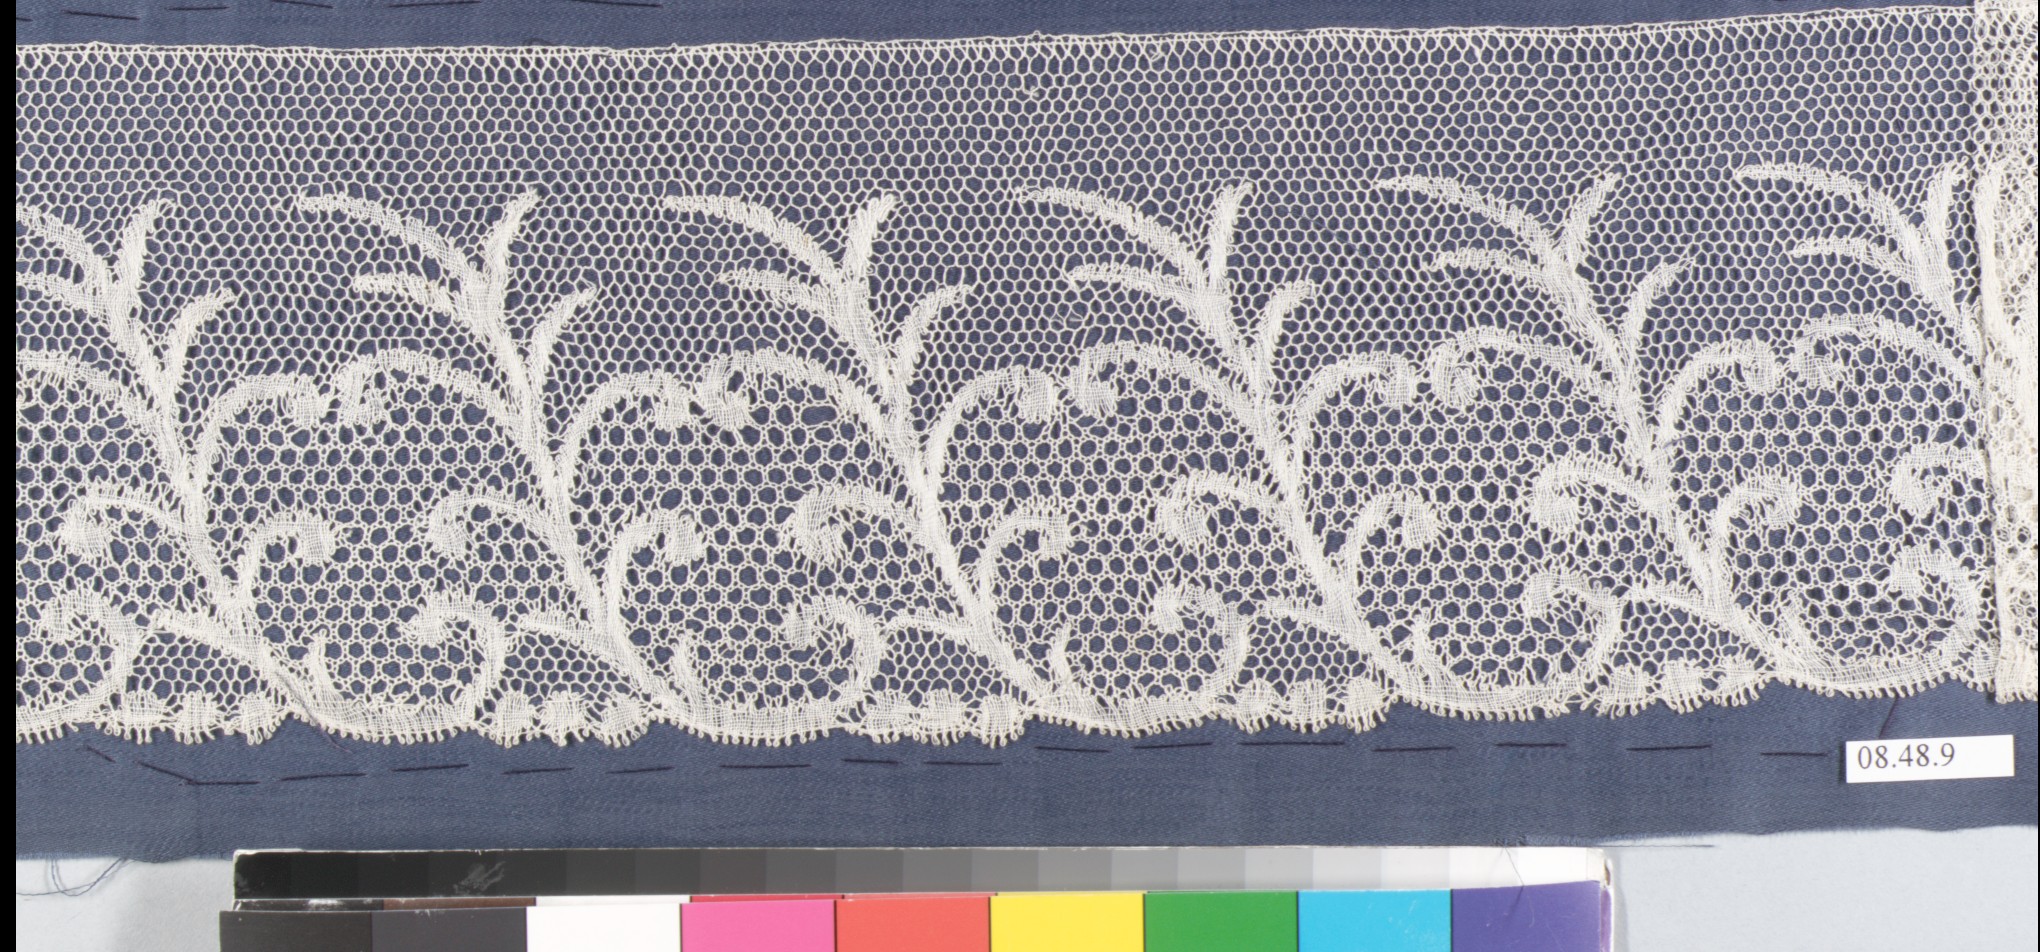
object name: edging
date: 1801-1900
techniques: lace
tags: plants